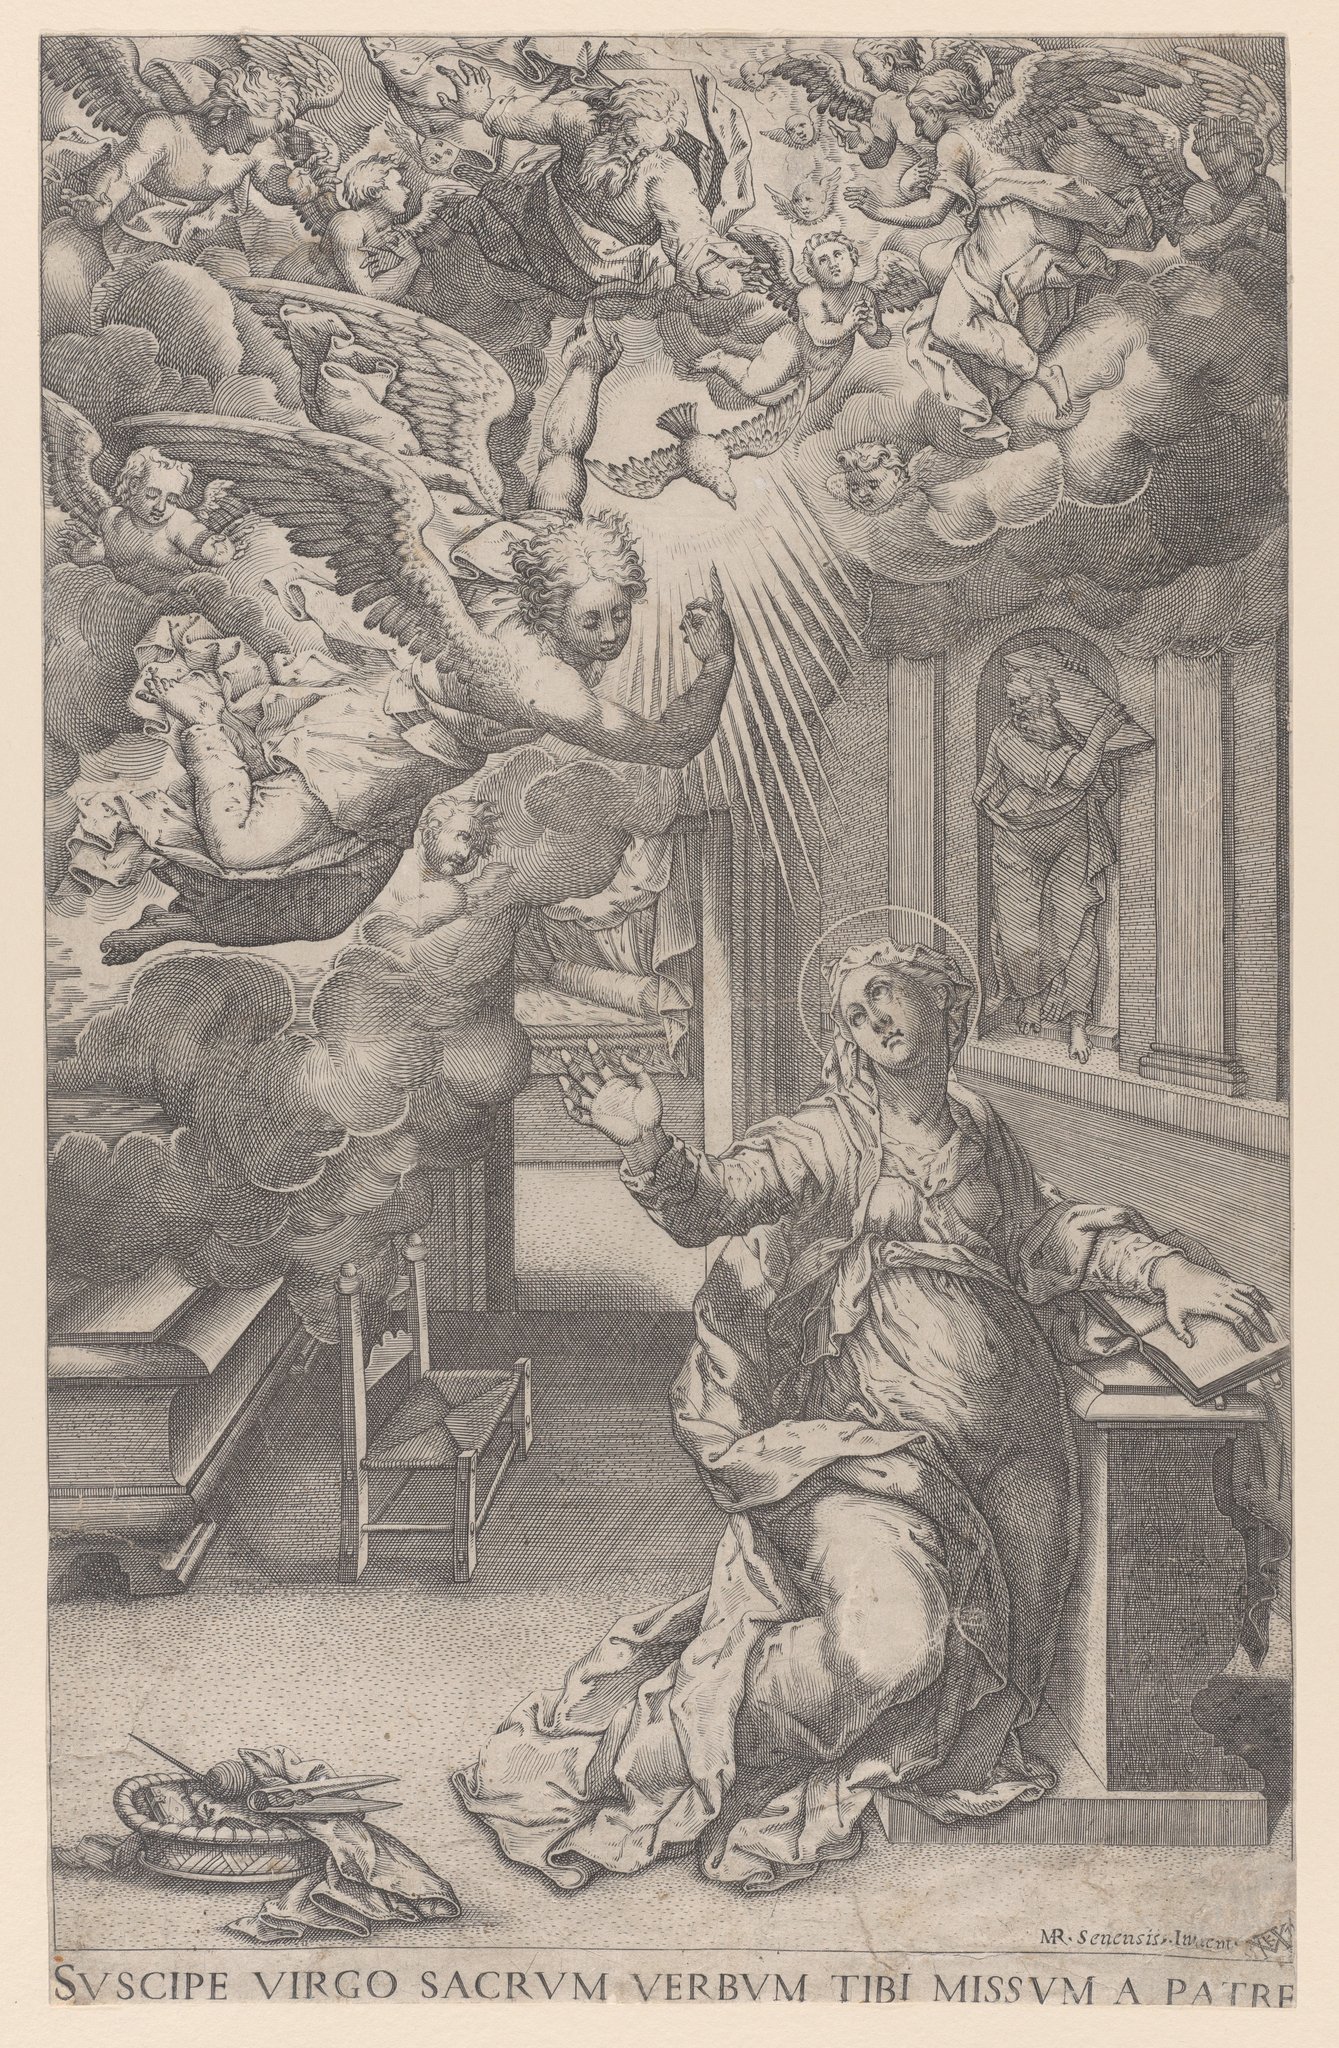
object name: print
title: The Annunciation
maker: mario cartaro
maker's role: artist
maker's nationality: italian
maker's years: 1557-1620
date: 1571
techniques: engraving